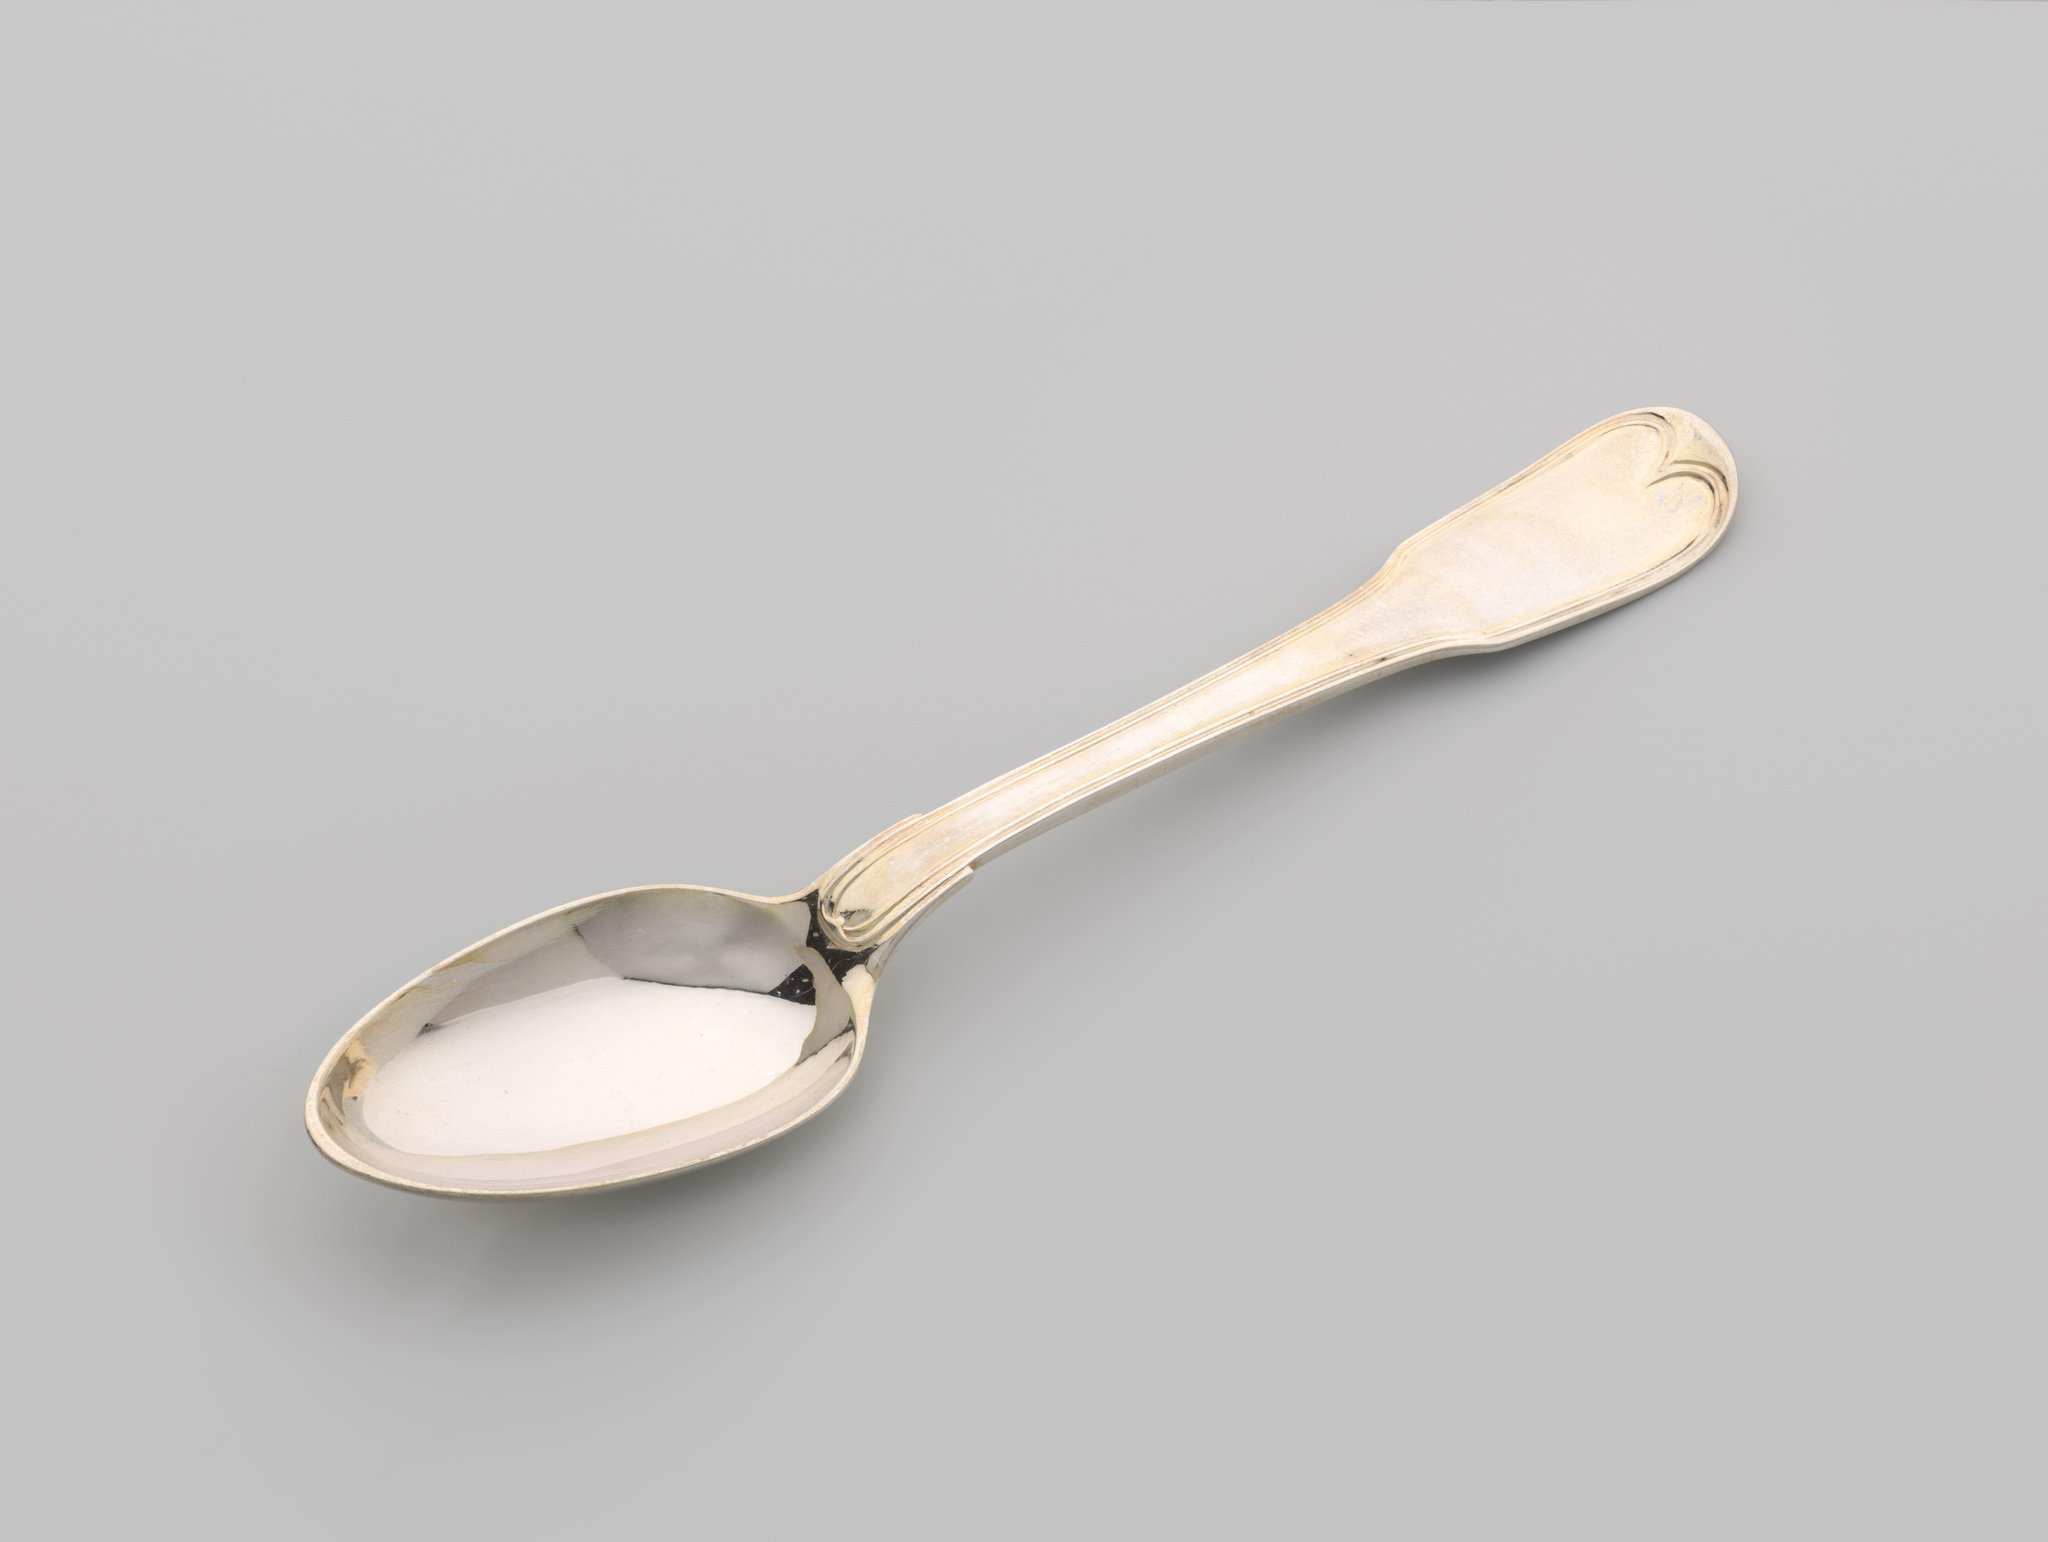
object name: spoon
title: Dessertlepel met het helmteken Clifford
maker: roelof helweg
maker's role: silversmith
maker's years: 1758-1843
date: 1806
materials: silver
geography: amsterdam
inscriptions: alloy mark, town mark, date letter: ‘X’, maker's mark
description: De eivormige bak van de lepel heeft een versmald uiteinde en is aan zowel boven- als onderzijde door middel van enkel lof verbonden met de platte, gebogen steel, die zich verbreedt naar het spatelvormige uiteinde. Boven- en onderzijde van de steel worden omgeven door een dubbele filetrand, die bij het uiteinde ingezwenkt is. Op de onderzijde van de spatel van zowel de lepels als de vorken is het helmteken Clifford gegraveerd.